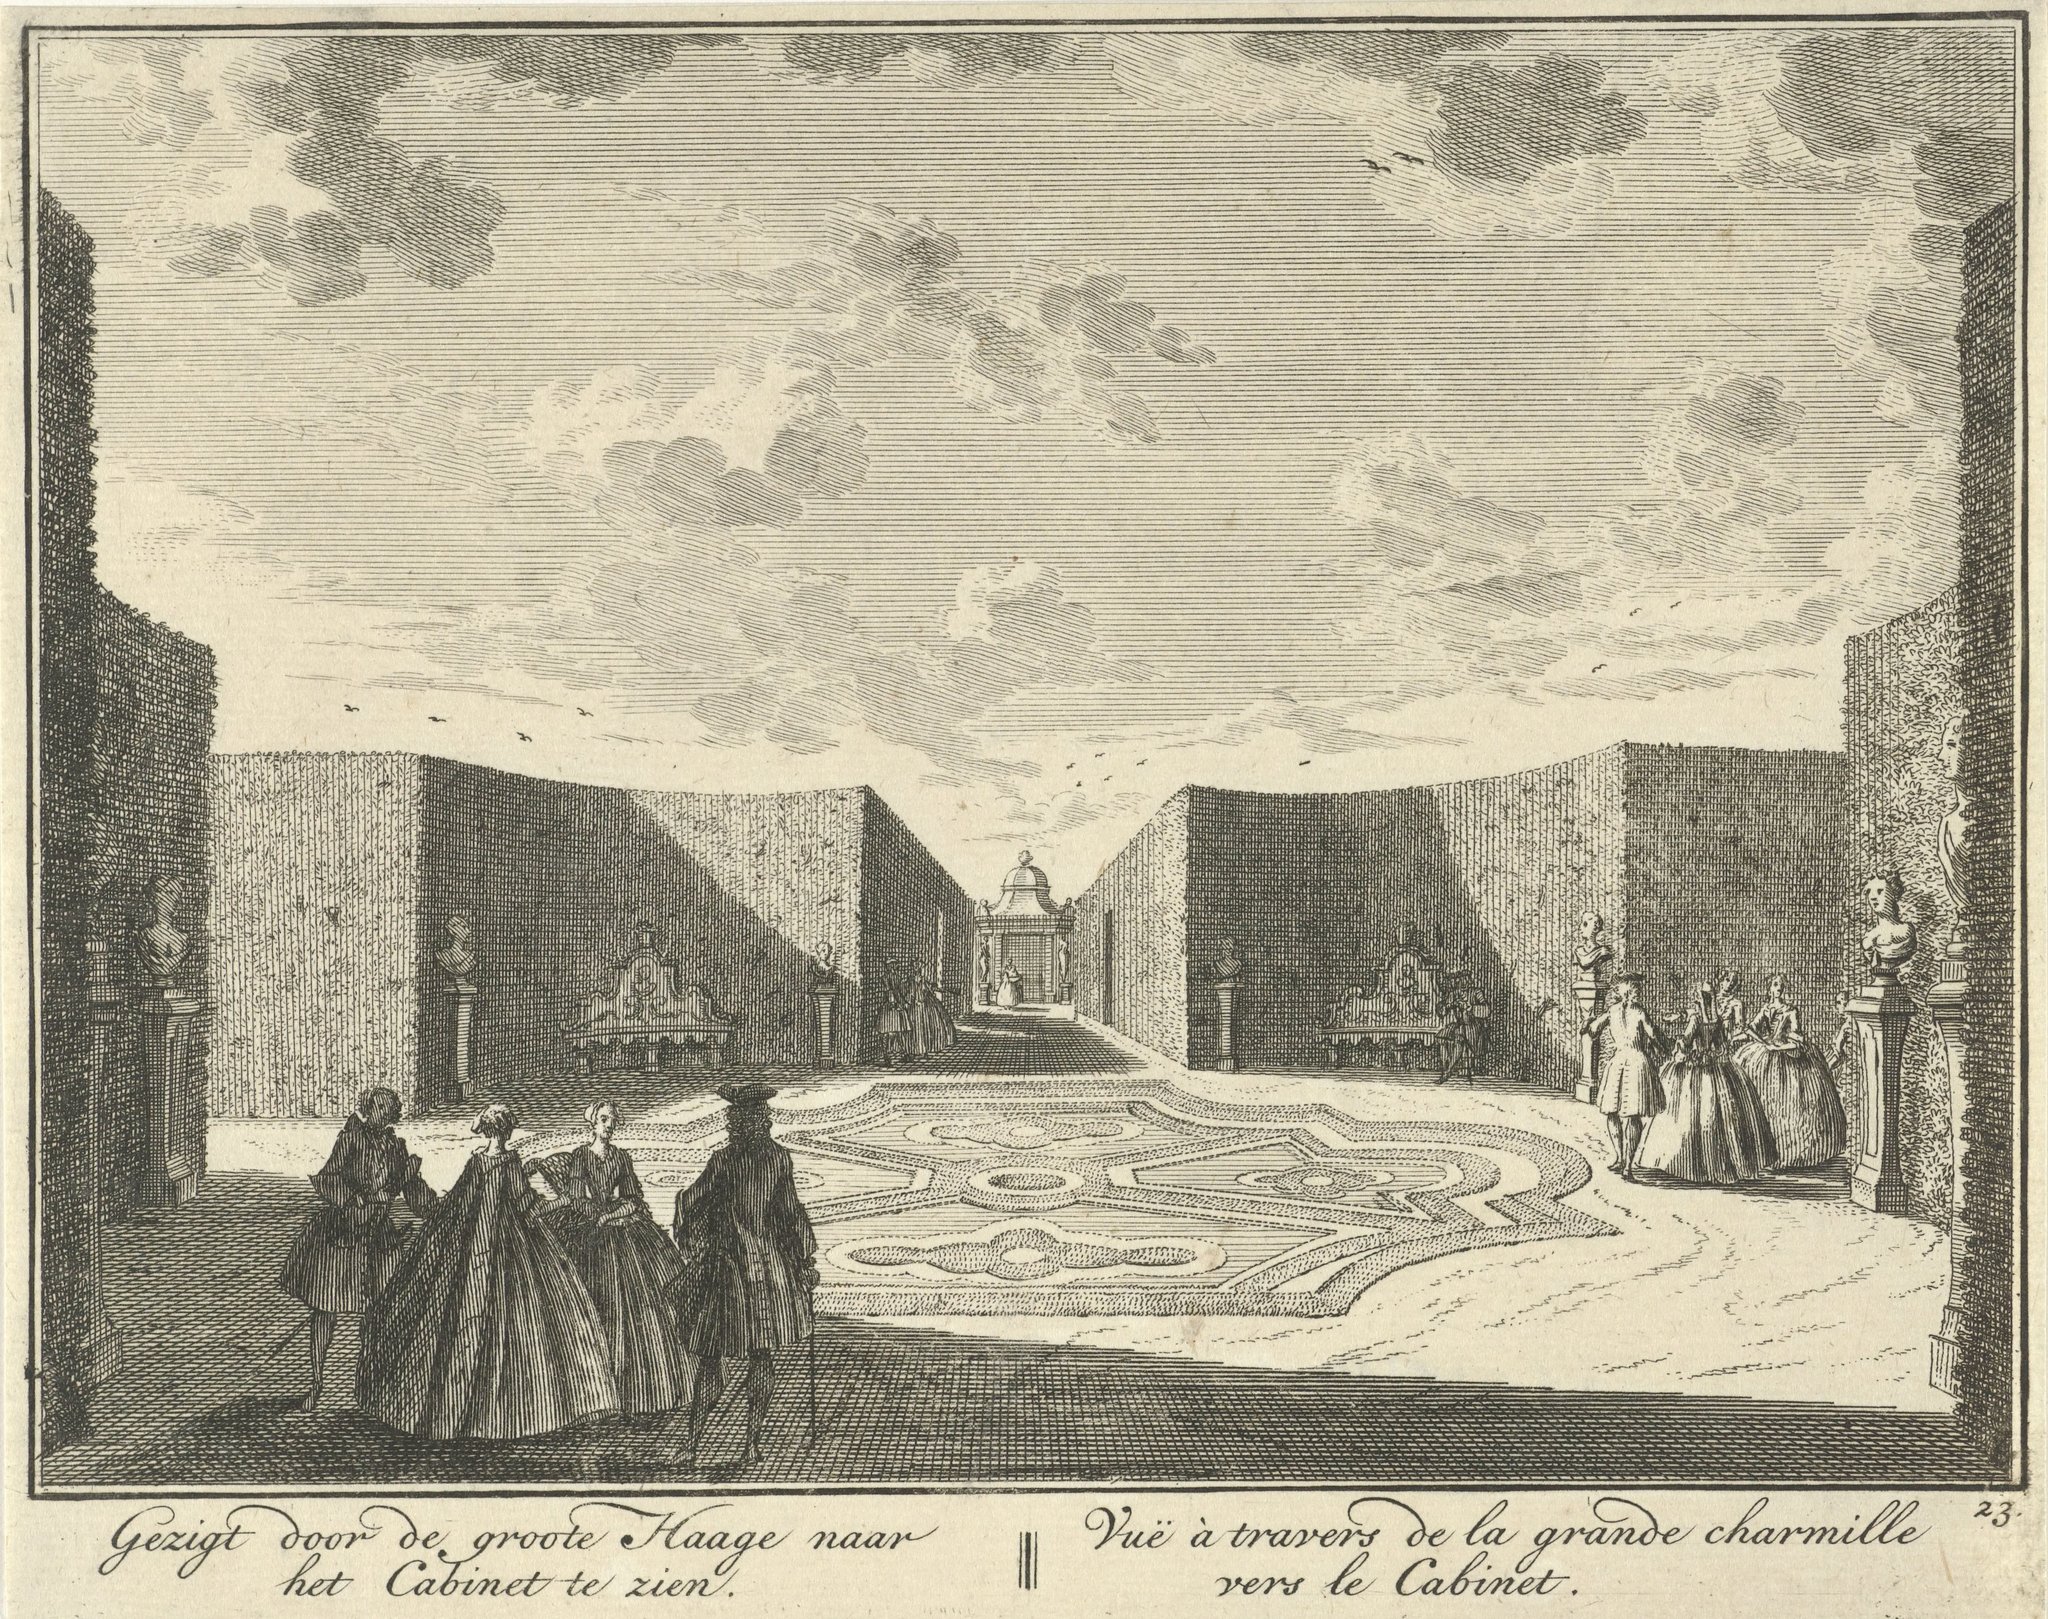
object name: print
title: Gezigt door de groote Haage naar het Cabinet te zien / Vue à travers de la grande charmille vers le Cabinet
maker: hendrik de leth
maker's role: draughtsman, print maker, publisher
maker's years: 1703-1766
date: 1740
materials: paper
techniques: etching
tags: french or architectonic garden; formal garden, country-house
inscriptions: collector's mark: Lugt 2228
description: Gezicht door de grote haag op het kabinet in de Franse tuin van Huis ter Meer. In de tuin staan twee converserende groepen figuren. De prent maakt deel uit van een serie met 26 gezichten op Huis ter Meer en het bijbehorende landgoed te Maarssen.